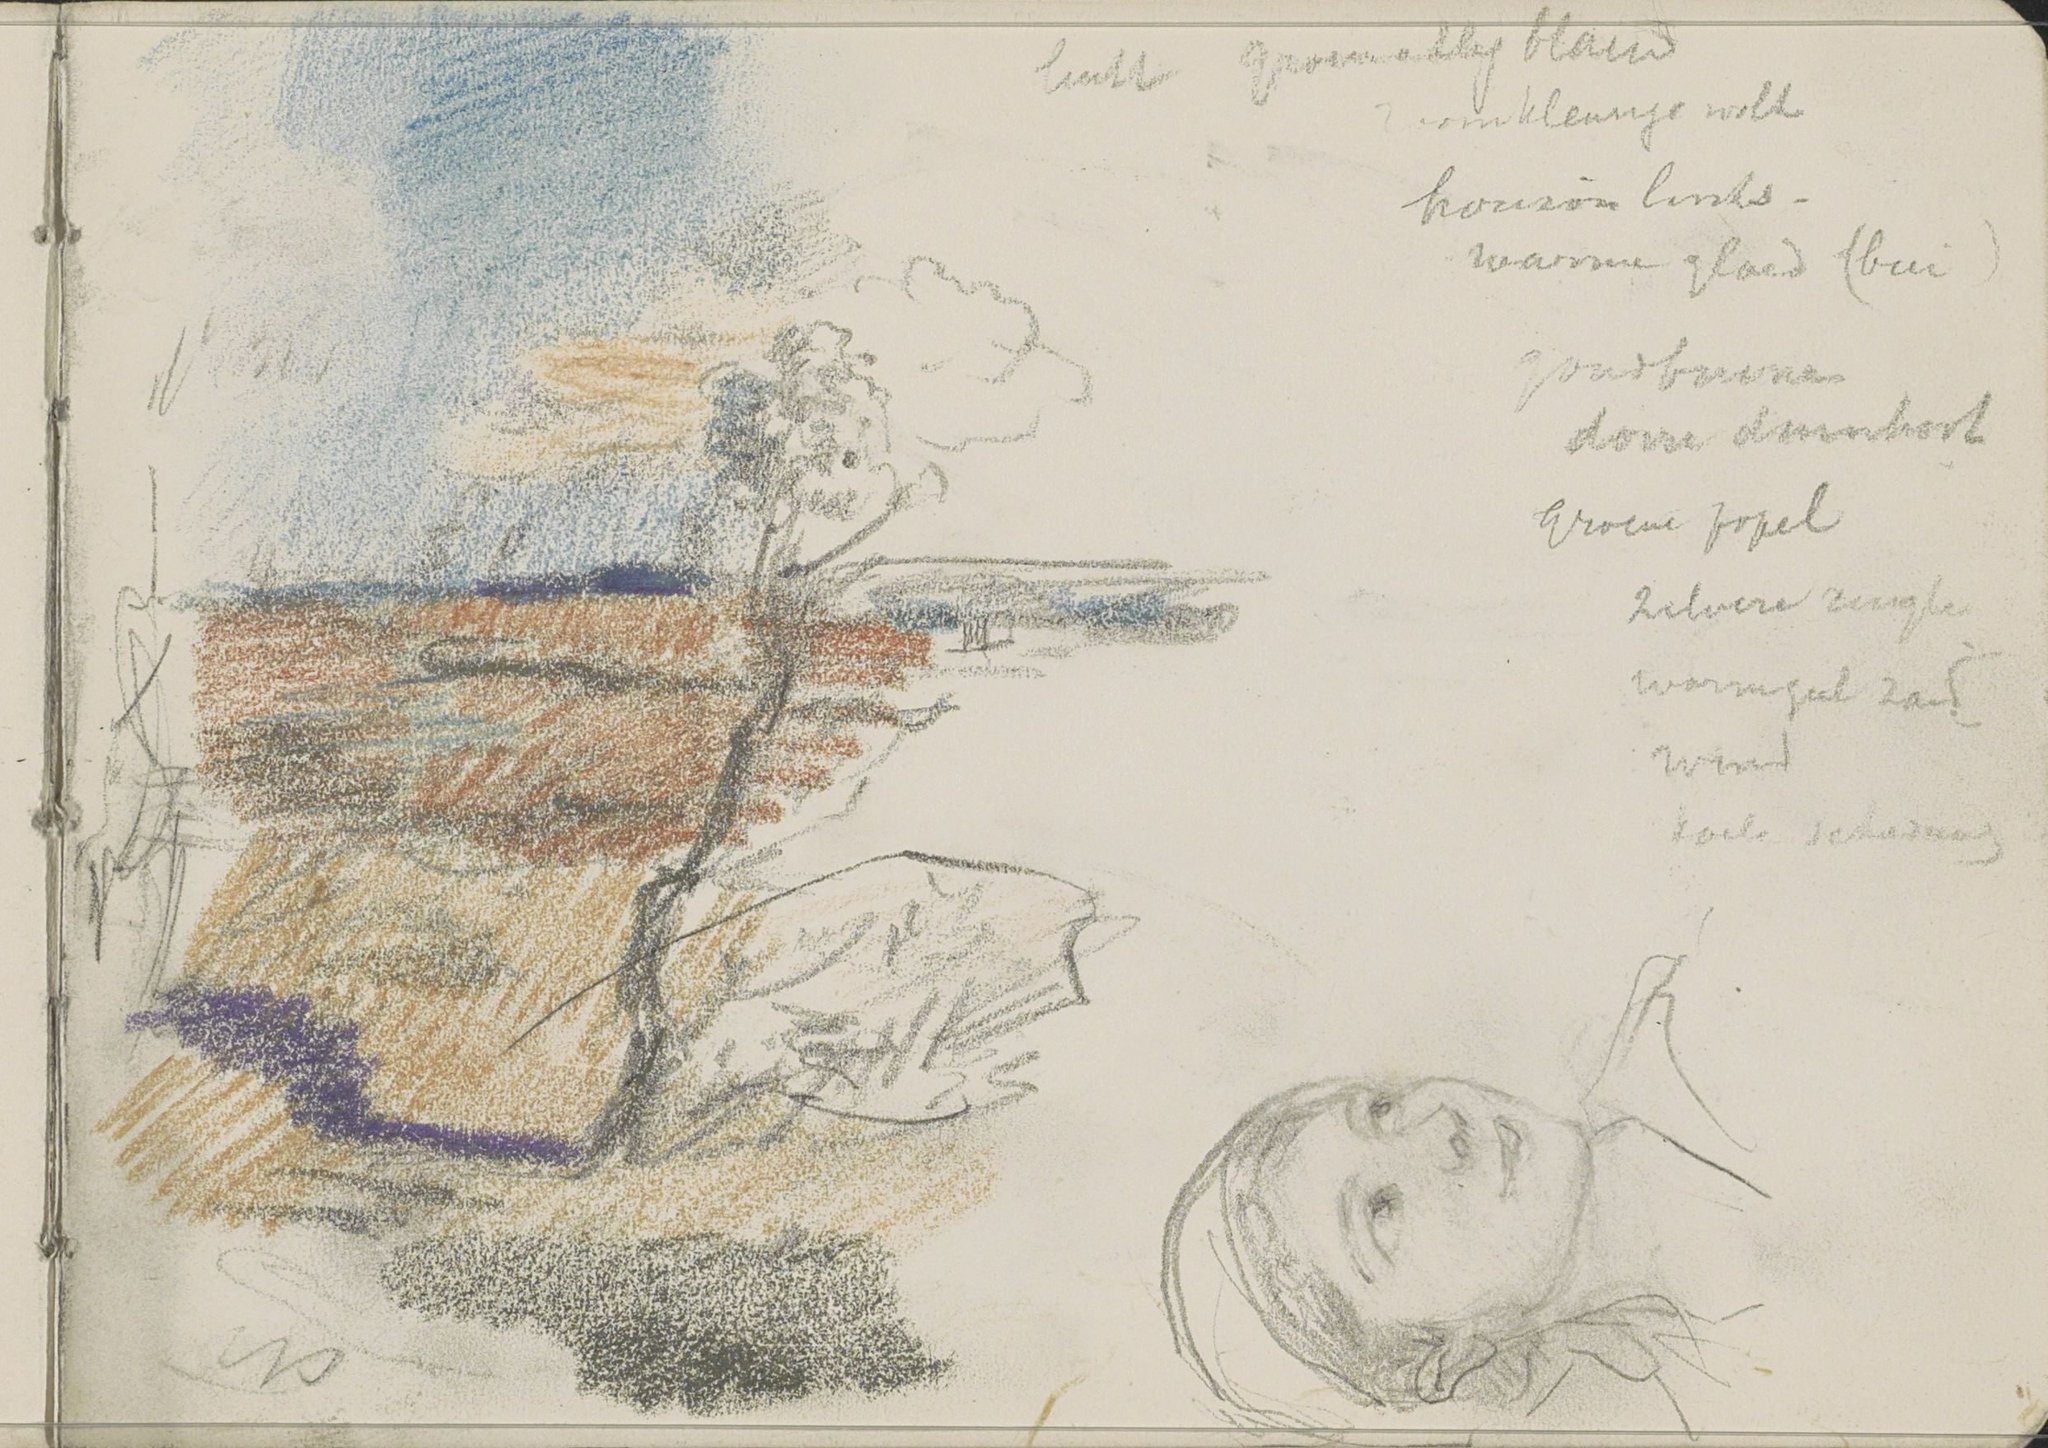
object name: sketchbook leaf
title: Duinlandschap en een vrouwenhoofd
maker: johan antonie de jonge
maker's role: draughtsman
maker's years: 1864-1927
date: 1881-1927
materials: chalk, paper, pencil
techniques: stumping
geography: south holland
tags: dune coast, head (human) - aa - female human figure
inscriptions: kleurnotitie, handgeschreven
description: Links een duinlandschap met in de verte de zee. Rechts een vrouwenhoofd. Blad 23 recto uit een schetsboek met 28 bladen.